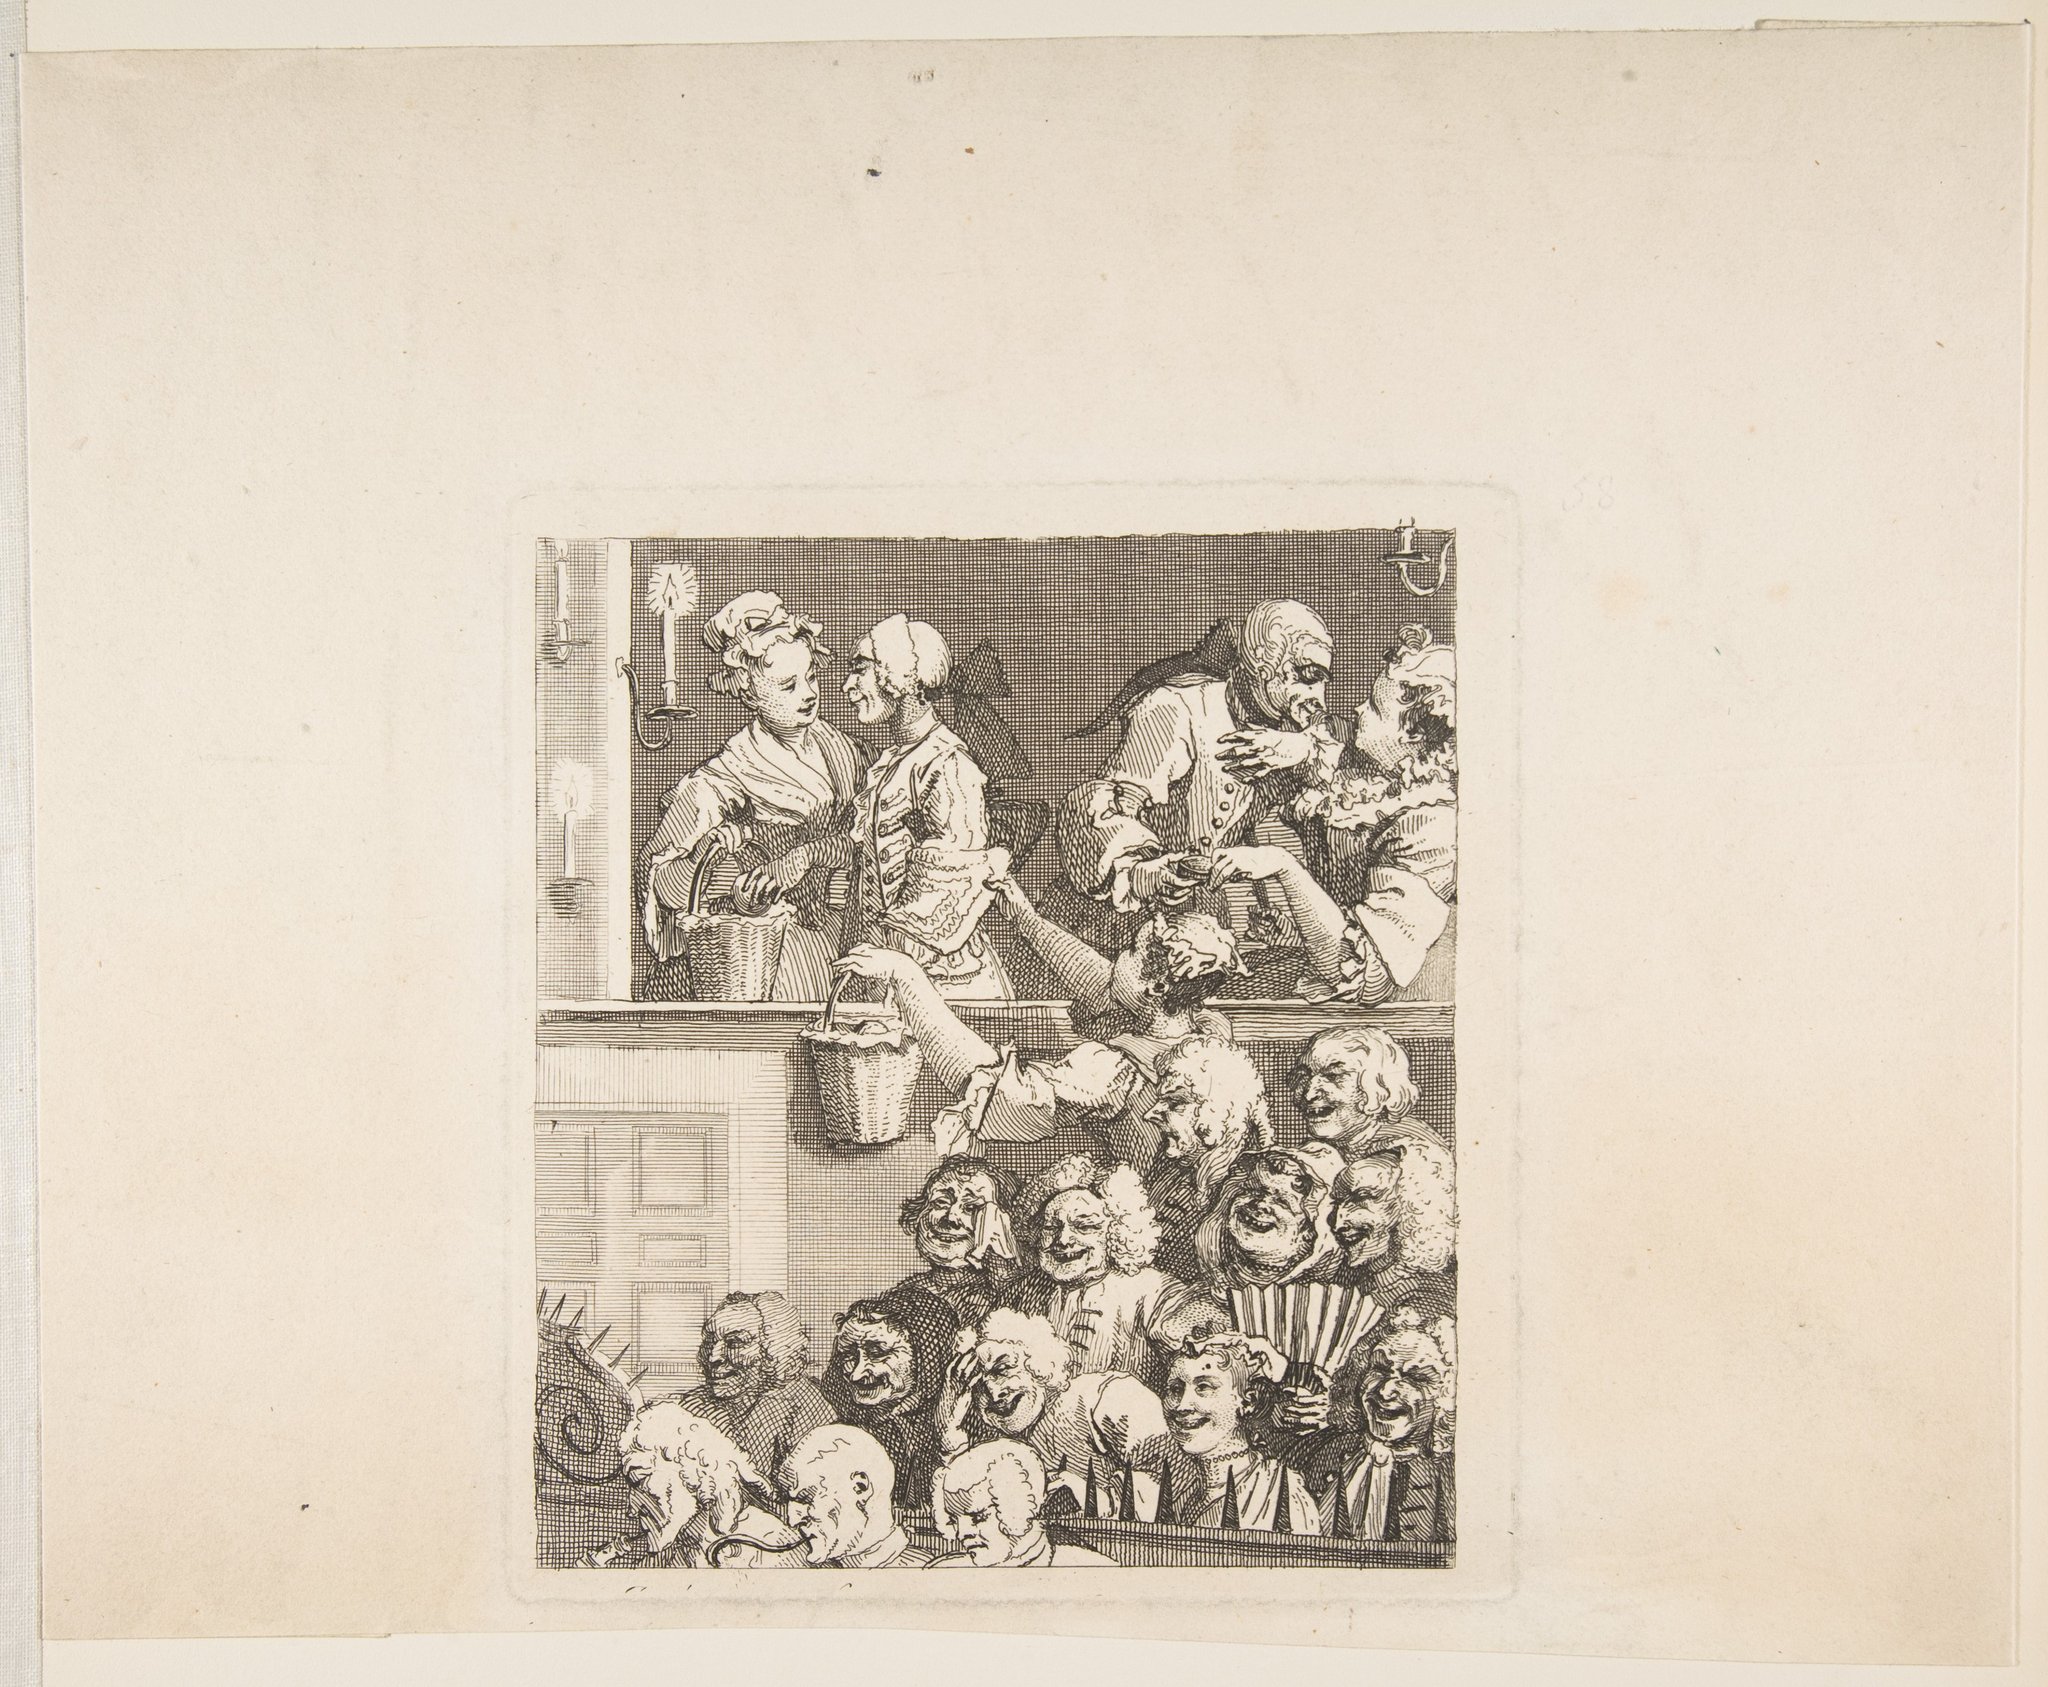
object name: print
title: The Laughing Audience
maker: william hogarth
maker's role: artist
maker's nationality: british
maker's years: 1697-1764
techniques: etching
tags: men,women,spectators